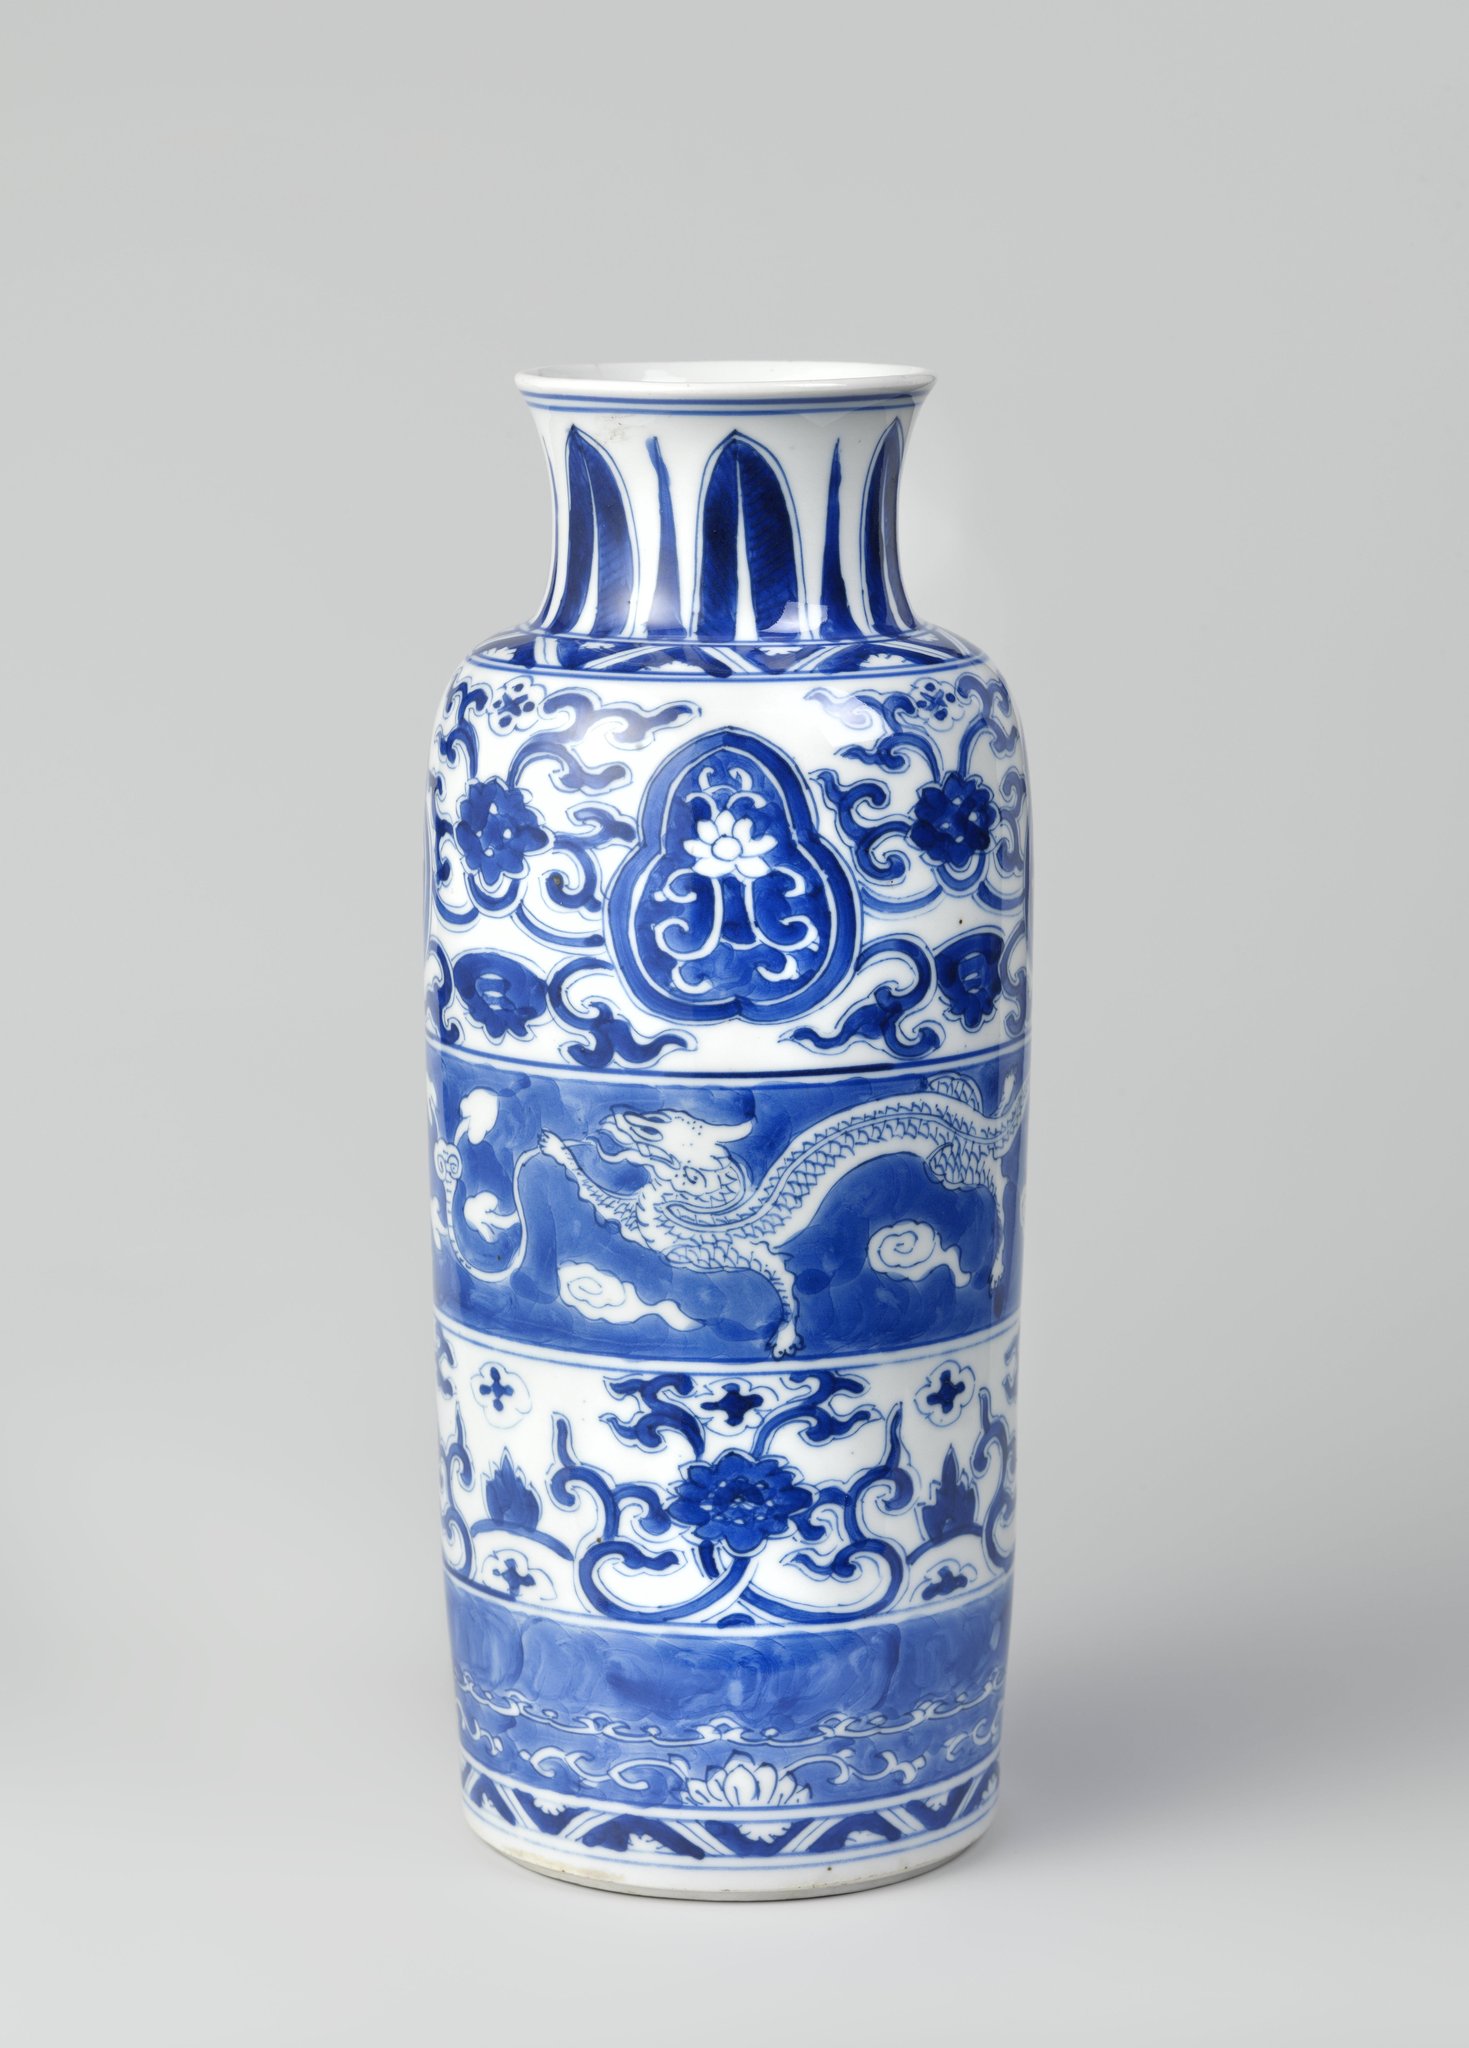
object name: vase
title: Cilindrical vase with dragons and floral scrolls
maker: Anonymous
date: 1700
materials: cobalt, glaze, paint, porcelain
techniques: firing, turning, vitrification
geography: china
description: AK-NM-6800 Twee vazen • Blauw-wit Kangxi-porselein • Lambrequin- of ruyi-ornament • Onderdeel van Royers porseleincollectie • Oorspronkelijk vier exemplaren (inventaris Van der Kellen 1876) • Gepubl9ceerd: Jörg 1997, nr. 102 De vorm van de vaas is een logisch vervolg op de populaire rolwagen uit Overgangsperiode. Voor de beschildering geldt wat mij betreft hetzelfde als voor de vazen AK-NM-6757: het is een vreemde opstapeling van horizontale decoratieve banden. Het resultaat van een zoektocht naar een nieuw decor, naar een type porselein dat voldeed aan de wensen van de Europese kopers nadat de handel vanaf 1685 weer begon op te bloeien. Dezelfde stapeling van motieven: draken tegen een blauwe achtergrond, ruyi-vormige velden met wit uitgespaarde bloemen, horizontale banden en een veelheid aan ornament, is terug te vinden op de bekende dragonder-vazen in Dresden [Zimmermann 1923, pl. 79]. August de Sterke, koning van Saksen verwierf er in 1717 151 door 600 ruiters te ruilen met de koning van Pruisen, Frederik Willem I. In 1723 bestelde hij er nog een aantal in Nederland. Hoelang Frederik Willem de vazen al in zijn collecties in Oranienburg en Charlottenburg had, is niet bekend, maar dat dit drukke decor in ieder geval in Dresden gewaardeerd werd in de jaren ’10 en ’20 van de 18de eeuw, duidt erop dat zulke volle beschilderingen ook toen nog salonfähig waren. Dat sluit slecht aan op mijn veronderstelde ontwikkeling van ‘druk en vol’ vroeg in de Kangxi-periode naar ‘rustig-beheerst’ aan het einde. Laten we maar zeggen dat dat een hoofdlijn is en dat natuurlijk alle smaken steeds leverbaar en geleverd werden. Mijn veronderstelling is dat deze stapeling van bandwerk met decoratiemotieven ontwikkeld is om tegemoet te komen aan een (veronderstelde) Europese smaak. Omdat het geheel in mijn ogen niet ‘Chinees’ overkomt en omdat ik geen Chinese voorbeelden kan bedenken waarin het wél te vinden is. Dat laatste moet genuanceerd worden. In de collectie van het Topkapi Museum bevindt zich een vaas uit de Jiajing-periode (1521-1567) die ook is beschilderd met een opeenstapeling van banden. Andere banden, maar toch dit principe [Krahl en Ayers 1986, vol. II, nr. 1033]. En men zou kunnen denken aan de mouw van een drakenmantel (bijv AK-RAK-2019-120). Daar keren de draken terug – gevat in een band – en de opstapeling van decoratieve banden. Het is nog steeds niet zo dat deze decoratiekeuze gemakkelijk in te passen is in een Chinese traditie, maar er zijn dus wel elementen aan te wijzen waarop het aansloot. Die aansluiting bood mogelijk een voedingsbodem waarop dit decor, dat toch primair voor buitenlandse markten bedacht zal zijn, zich kon ontwikkelen. De vaas werd blijkbaar een commercieel succes, want er zijn er veel te vinden in Nederlandse en Engelse collecties [Cheng 2009, nrs. 39-39, Jörg 1997 voor refs]. Het Rijksmuseum heeft identieke stukken afkomstig van de kunstschilder Jacob Eduard van Heemskerck van Beest (1828-1894) en van Jean Charles Joseph Drucker (1862-1944). Van Drucker is bekend dat hij ze op 15 maart 1888 kocht op de veiling van de collectie van captain Lukis (over wie verder niets bekend is) [Van Campen 2008, p. 25]. Waarom moeten we dit allemaal weten? Dit illustreert de geschiedenis van de waardering voor blauw-wit Kangxi aan het eind van de 19de eeuw. Die bloei begon in Engeland bij schilders als James McNeill Whistler (1834-1903) en Dante Gabriel Rosetti (1828-1882). In hun kielzog ontstond een groep fervente verzamelaars in Engeland [Merill 1998, Williamson 1919, Wainwright 2002]. Londen werd het centrum van de porseleinhandel en zeer grote hoeveelheden porselein werden door handelaren in Nederland (toen nog steeds het walhalla hiervoor) naar Londen verscheept. Deze vazen kregen daar een eigen naam: dragon on band. Royers vazen zijn een voorbeeld van wat in Nederland als vanzelfsprekend aanwezig was. Bronnen: G.C. Williamson, Murray Marks and his friends: a tribute and a regard, Londen, 1919. Ernst Zimmermann, Chinesisches Porzellan und die übrigen keramischen Erzeugnisse Chinas, Leipzig, 1923. Regina Krahl en John Ayers, Chinese ceramics in the Topkapi Saray Museum, Istanbul: a complete catalogue, Londen, 1986. Christiaan J.A. Jörg, Chinese ceramics in the collection of the Rijksmuseum, Amsterdam: the Ming and Qing dynasties, Londen, 1997. Linda Merrill, The Peacock Room: a cultural biography, Washington, 1998. C. Wainwright, 'A Gatherer and Disposer of Other Men's Stuffe': Murray Marks, Connoisseur and Curiosity Dealer’, Journal of the History of Collections, 14 (1), pp. 161–76. Jan van Campen, ‘Londens aankopen van J.C.J. Drucker’, Aziatische Kunst 38/4 (2008), pp. 22-31. Cheng Xiejun (red.), Traces of the trade: Chinese export porcelain donated by Henk B. Nieuwenhuys (tent.cat. Shanghai Museum), Shanghai, 2009.